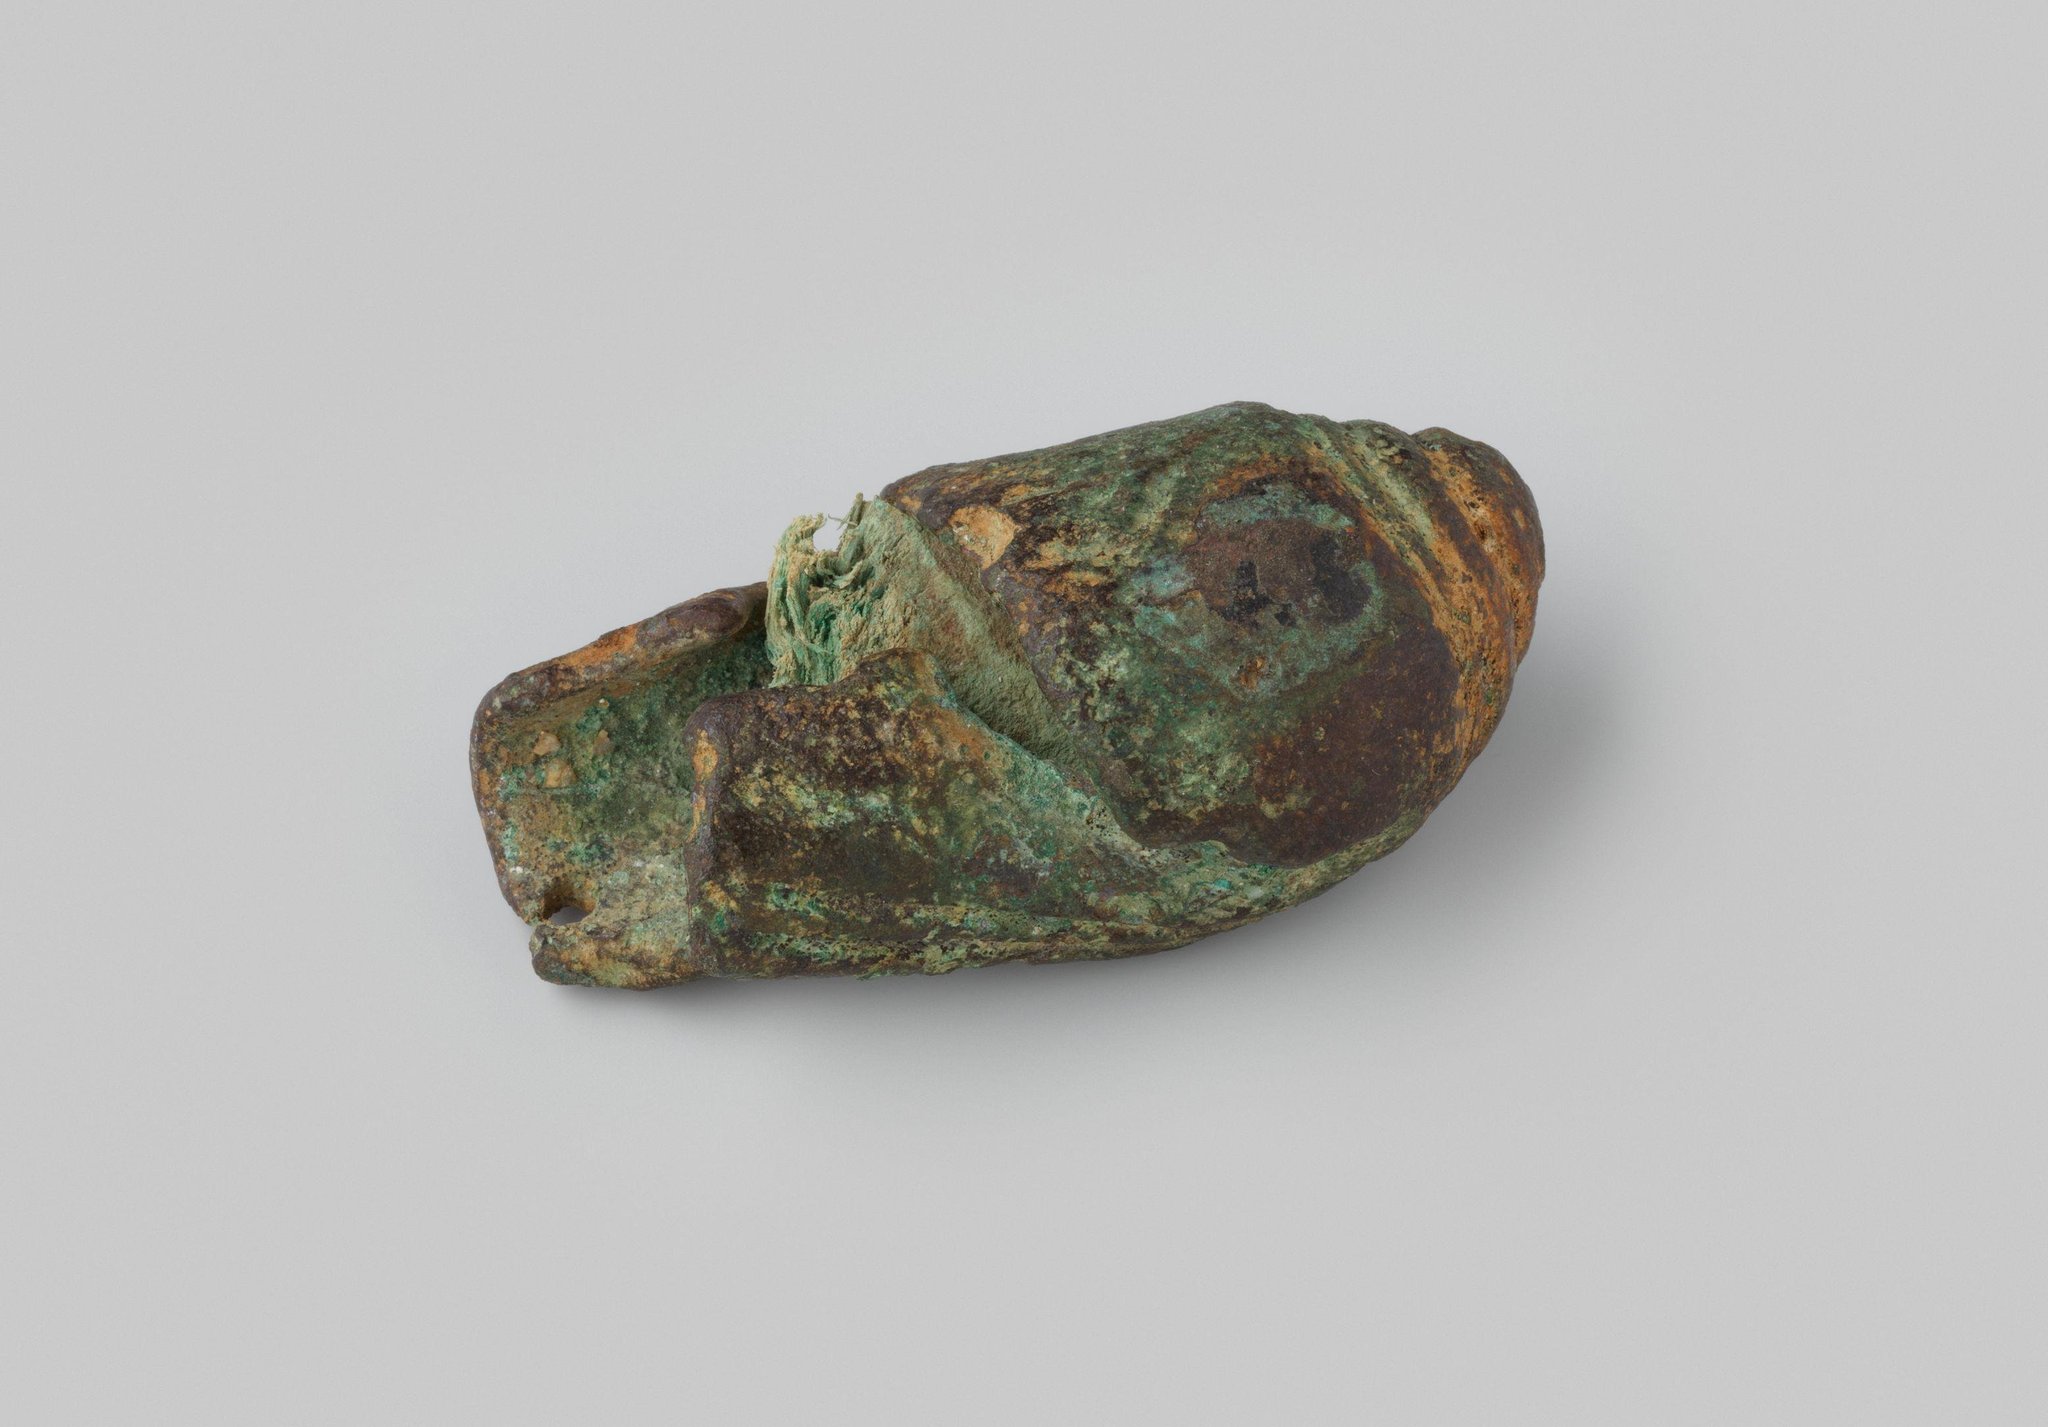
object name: clamp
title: Klem afkomstig uit het wrak van de Oost-Indiëvaarder Hollandia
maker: Anonymous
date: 1700-1743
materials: copper, wood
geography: netherlands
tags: verenigde oostindische compagnie, hollandia (schip)